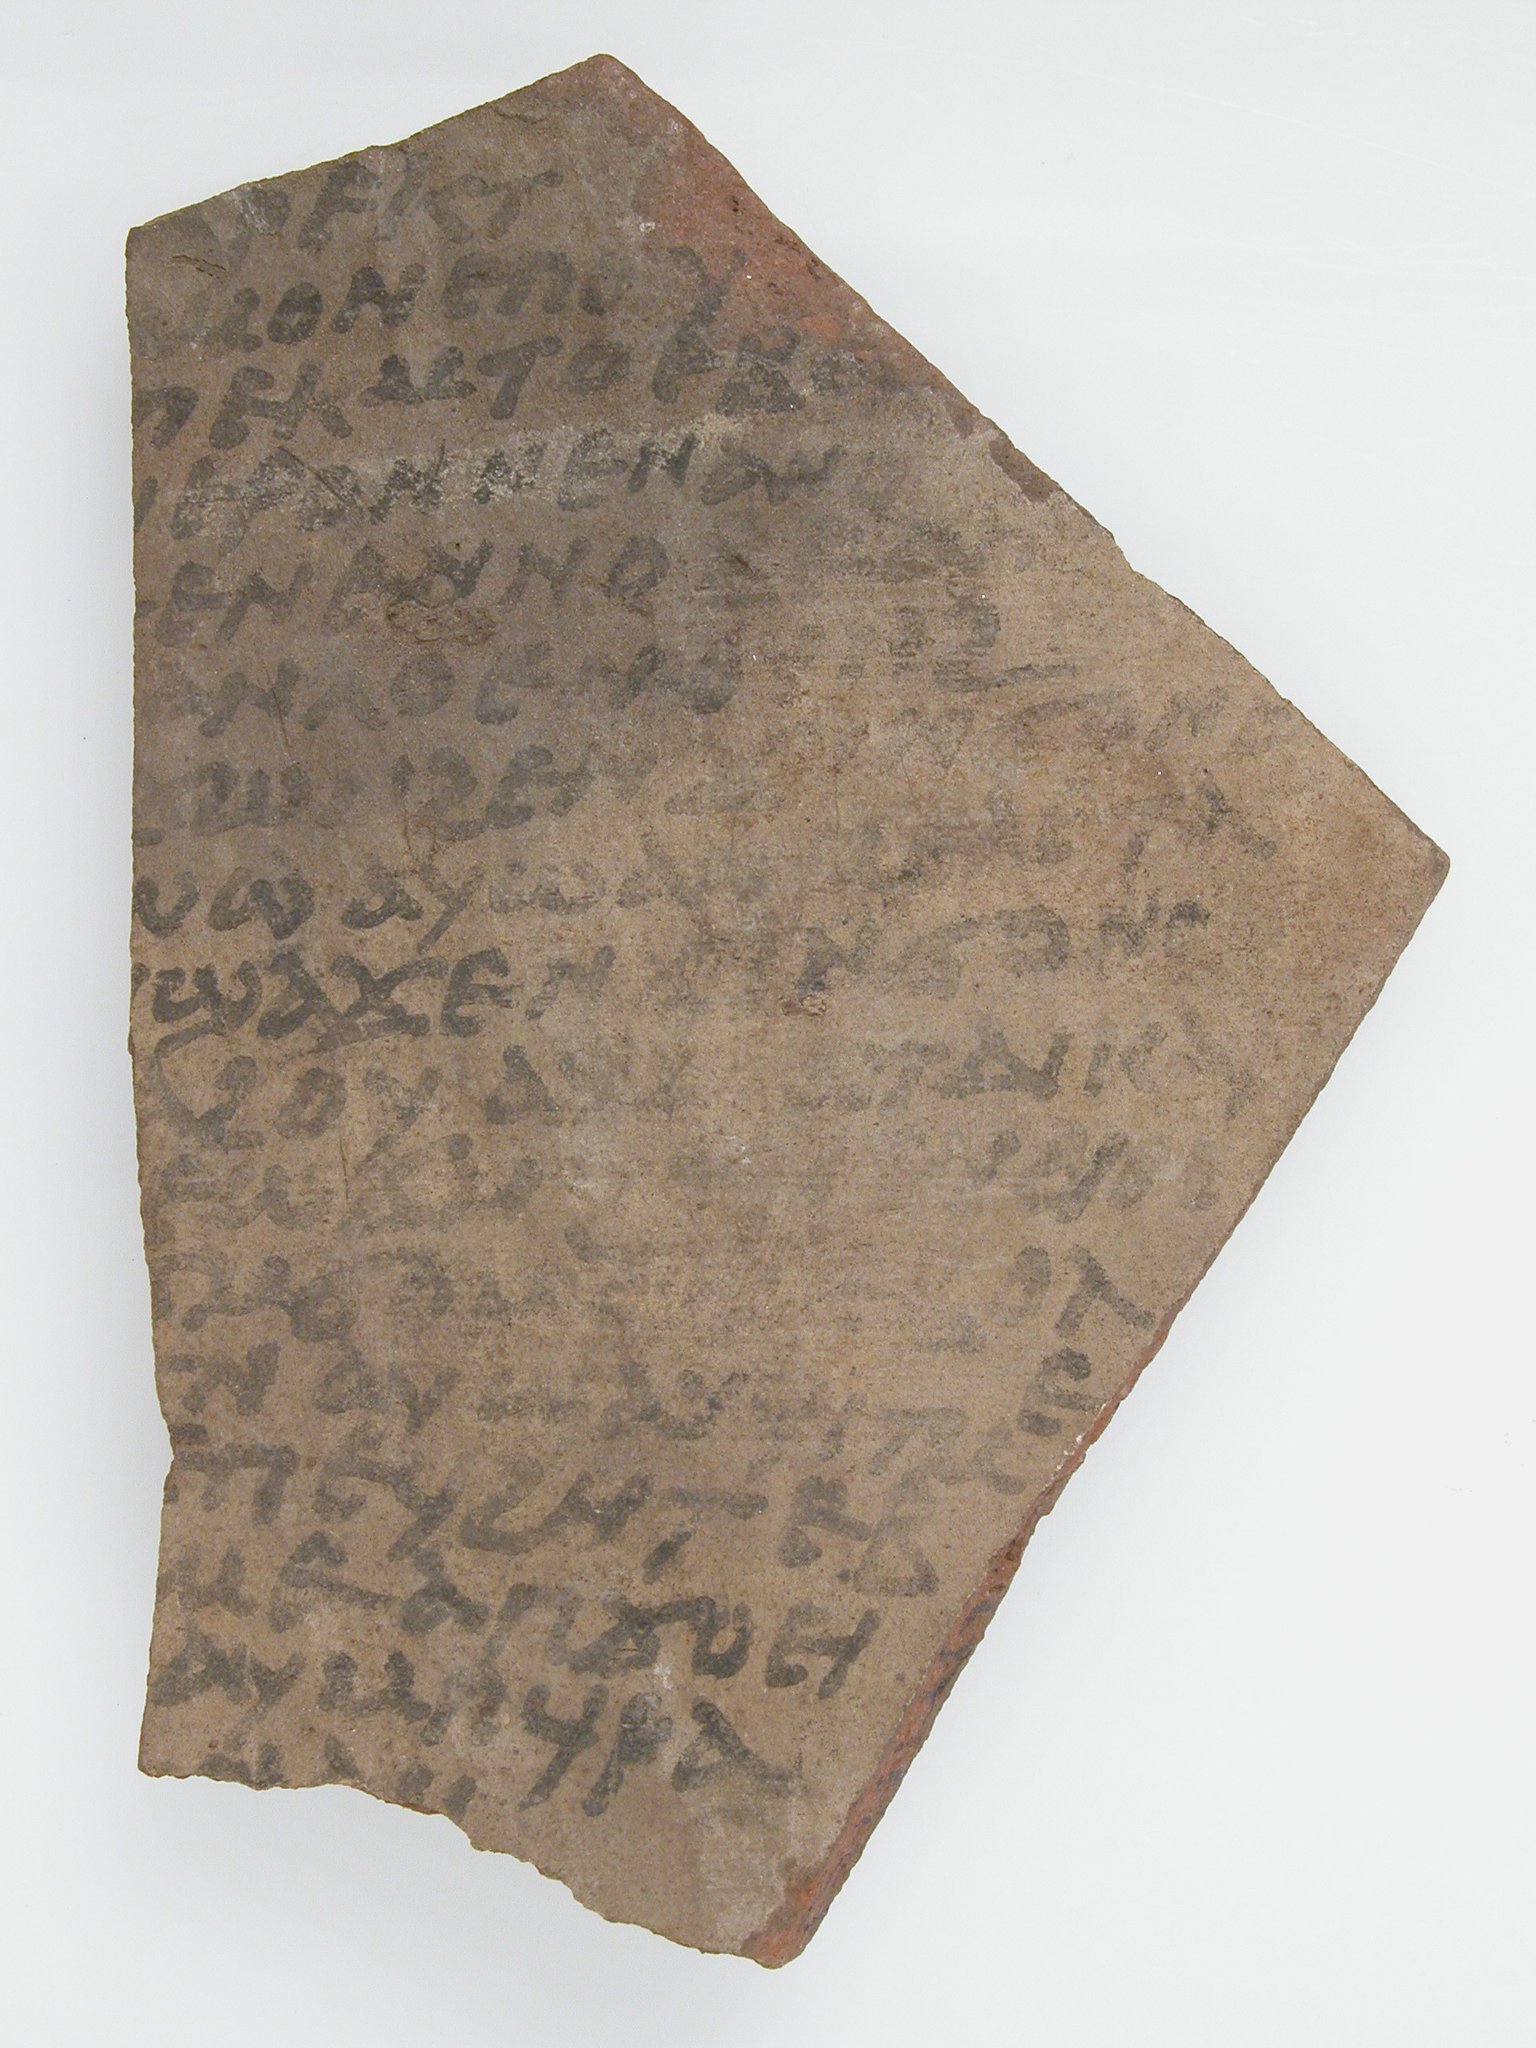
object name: ostrakon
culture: coptic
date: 601-700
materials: ink, pottery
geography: egypt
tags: documents